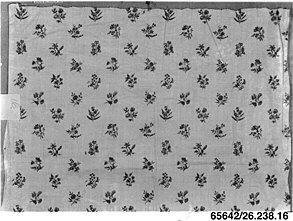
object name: piece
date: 1775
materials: cotton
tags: flowers